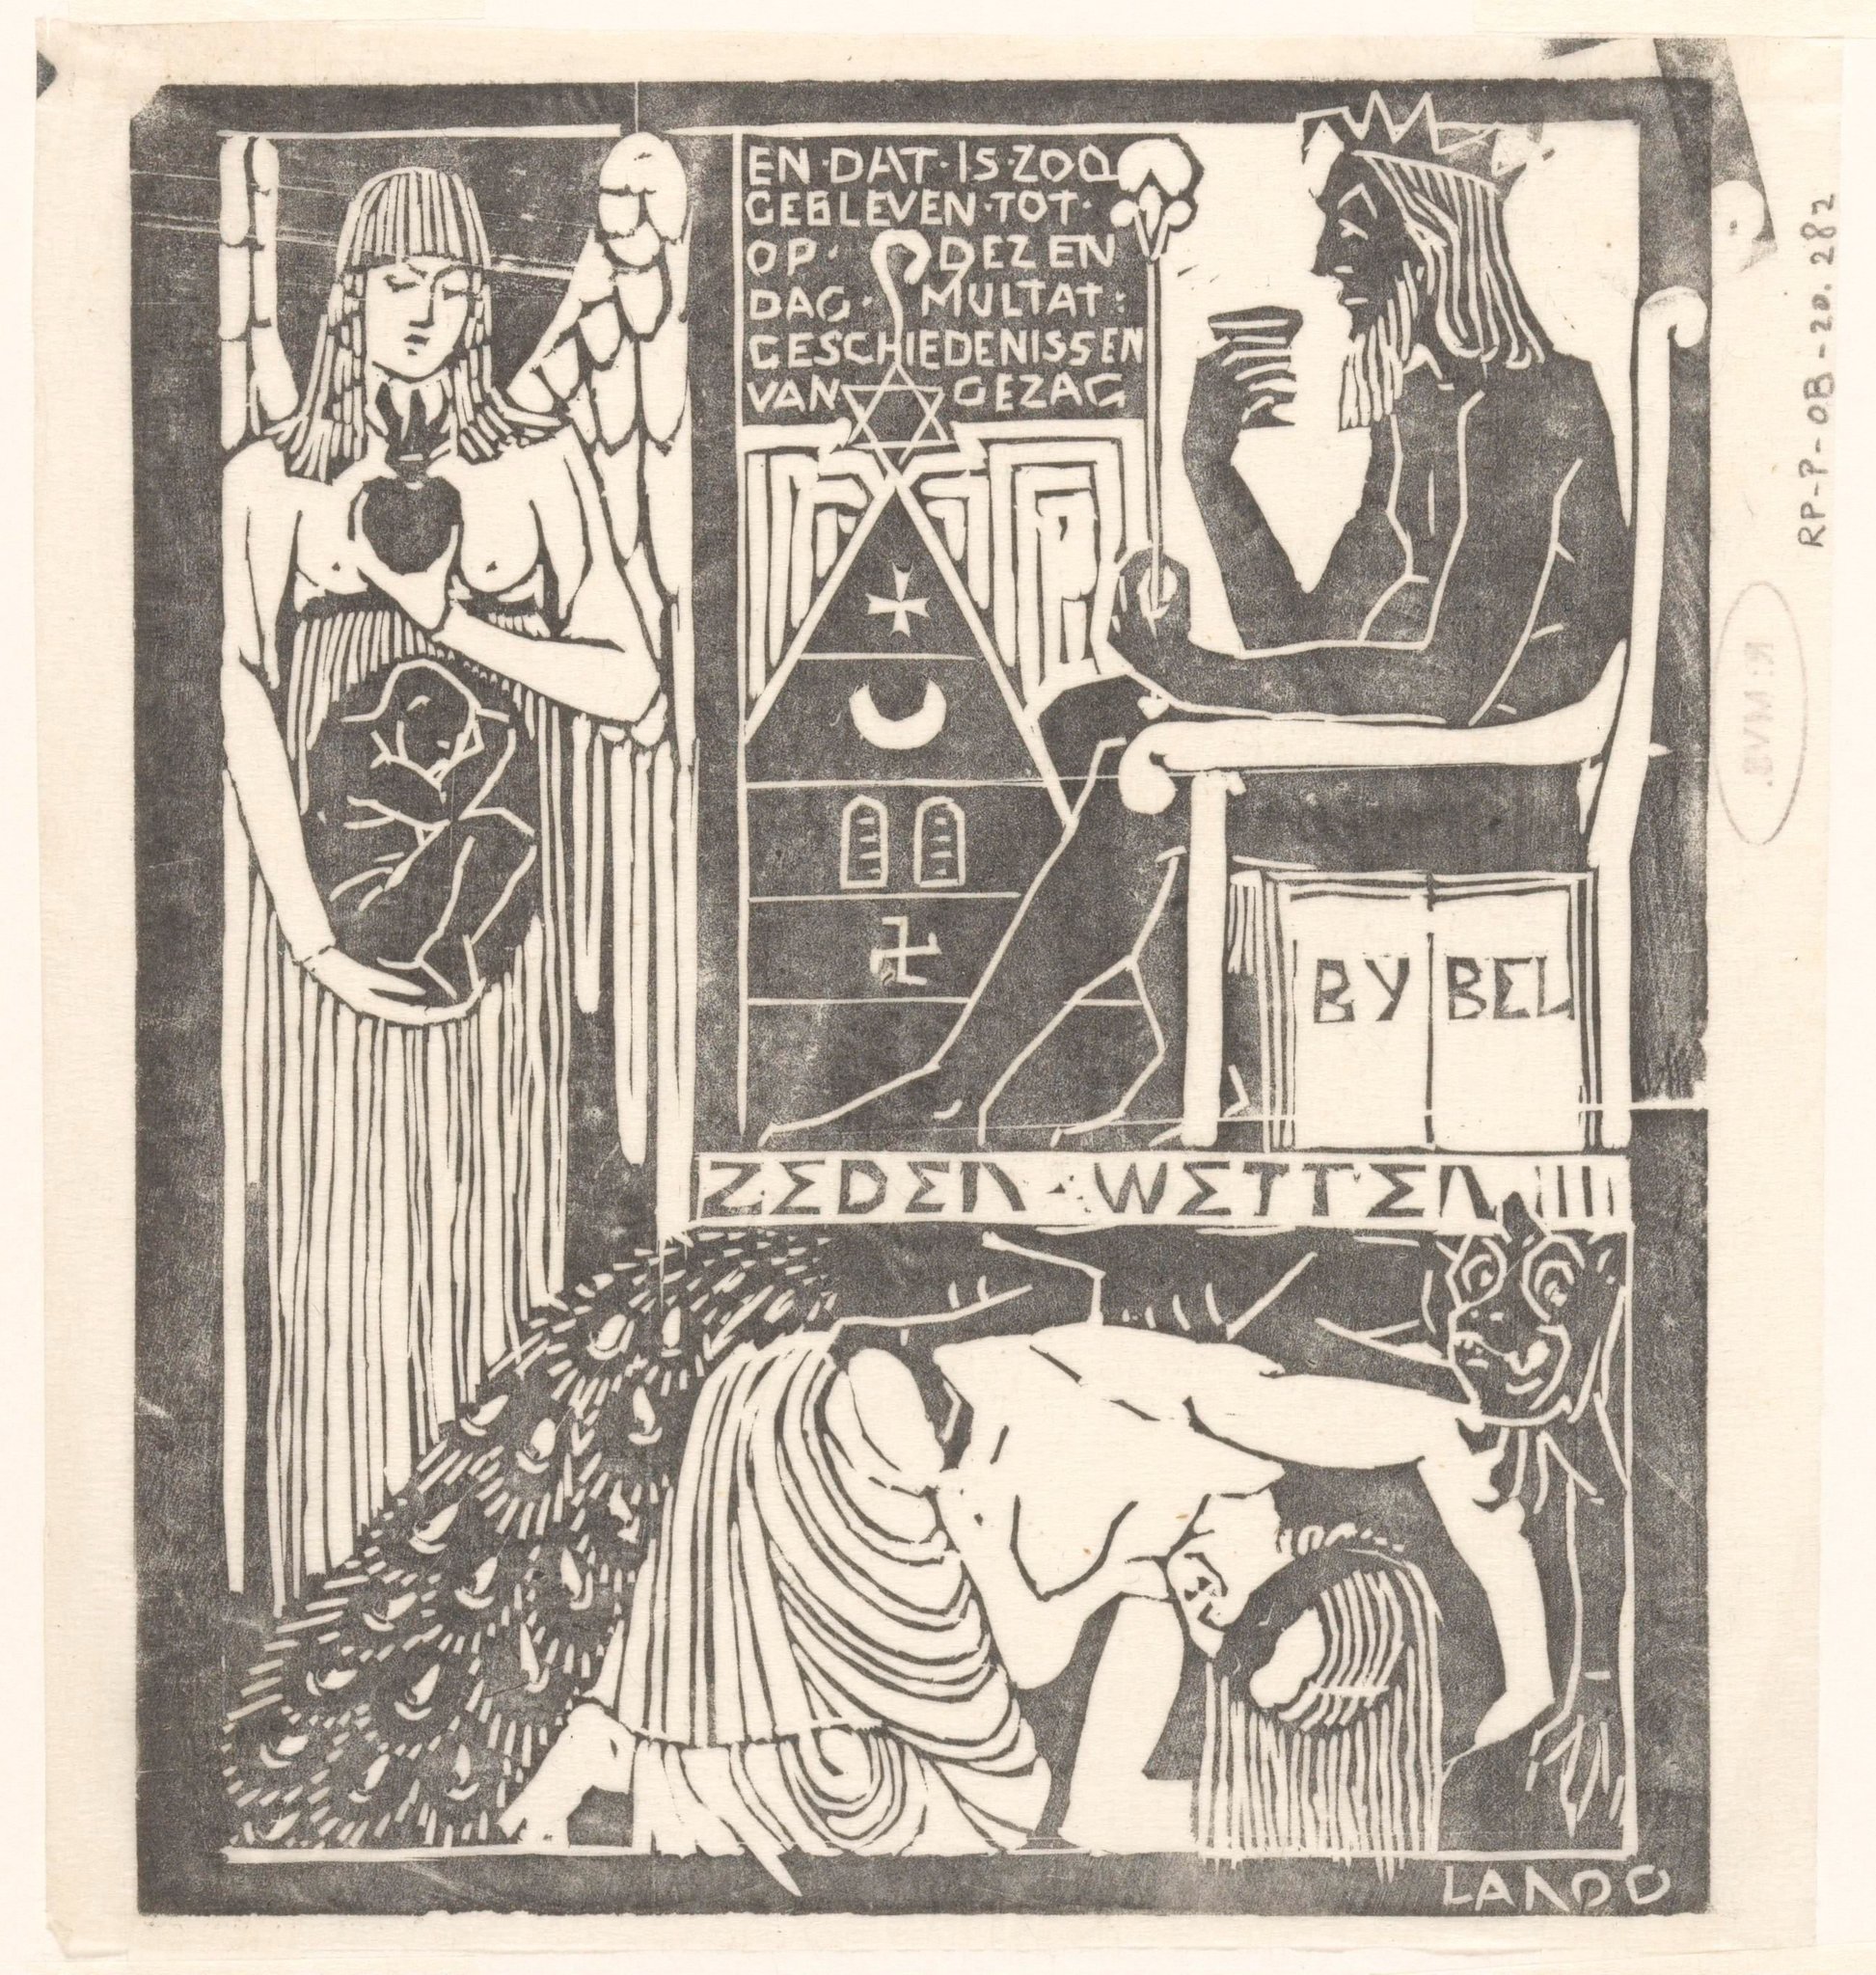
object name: print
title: Geblinddoekte vrouw en monster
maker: mathieu lauweriks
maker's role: designer, draughtsman, print maker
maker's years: 1864-1932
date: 1894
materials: paper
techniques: woodcut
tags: uterus with foetus - aa - female human figure, monsters ~ animals in general (of undetermined kind), the sacred heart, blindfold - aa - female human figure, the bible as a book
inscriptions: collector's mark: Lugt 2228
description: Een geblinddoekte vrouw zit op haar knieën met op haar rug een monster met een pauwenstaart. Boven haar de tekst 'zeden - wetten' en een bijbel. Daarboven zit een man met een kroon en een scepter op een stoel. Links staat een gevleugelde vrouw met in haar hand een heilig hart en in haar buik een figuur in foetushouding.